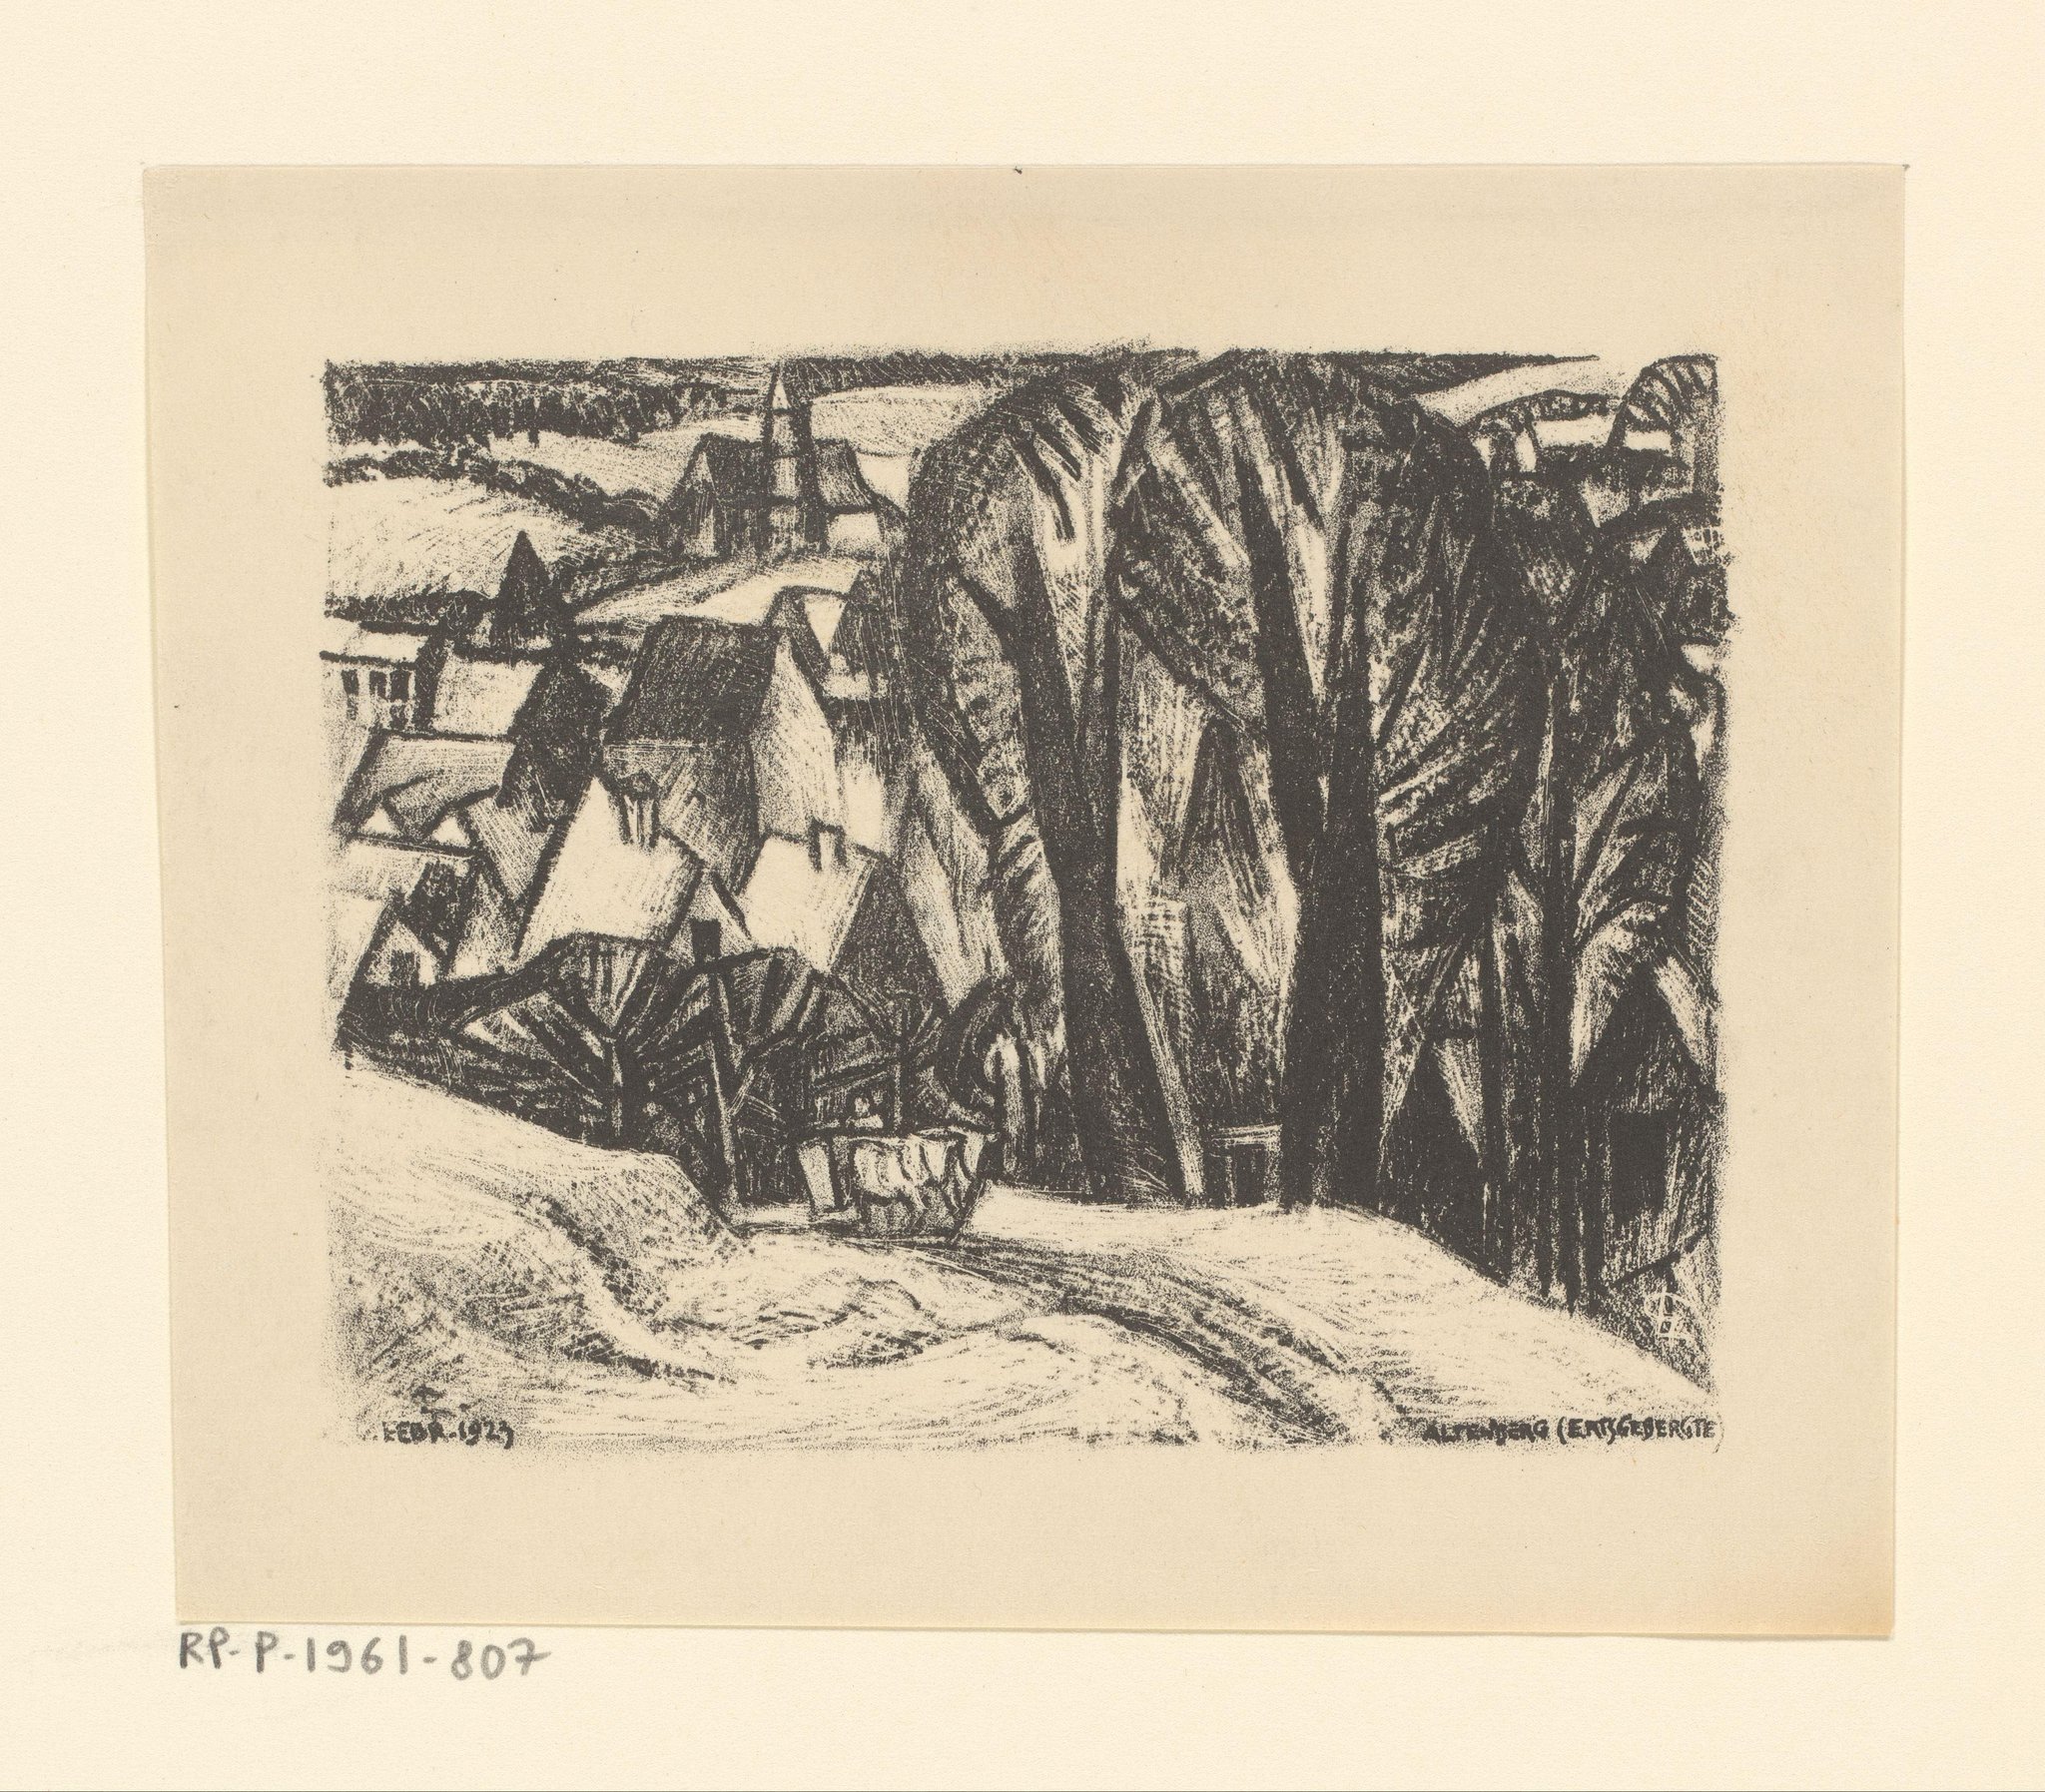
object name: print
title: Altenberg (Ertsgebergte)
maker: leo gestel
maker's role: draughtsman, print maker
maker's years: 1881-1941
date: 1902-1923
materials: paper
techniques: lithograph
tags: city-view, and landscape with man-made constructions, snow, ox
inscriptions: collector's mark: Lugt 2228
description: Zicht op de stad Altenberg in het Duitse Saksen vanaf een heuvel. Op de heuvel een ossenkar. Het landschap is besneeuwd.